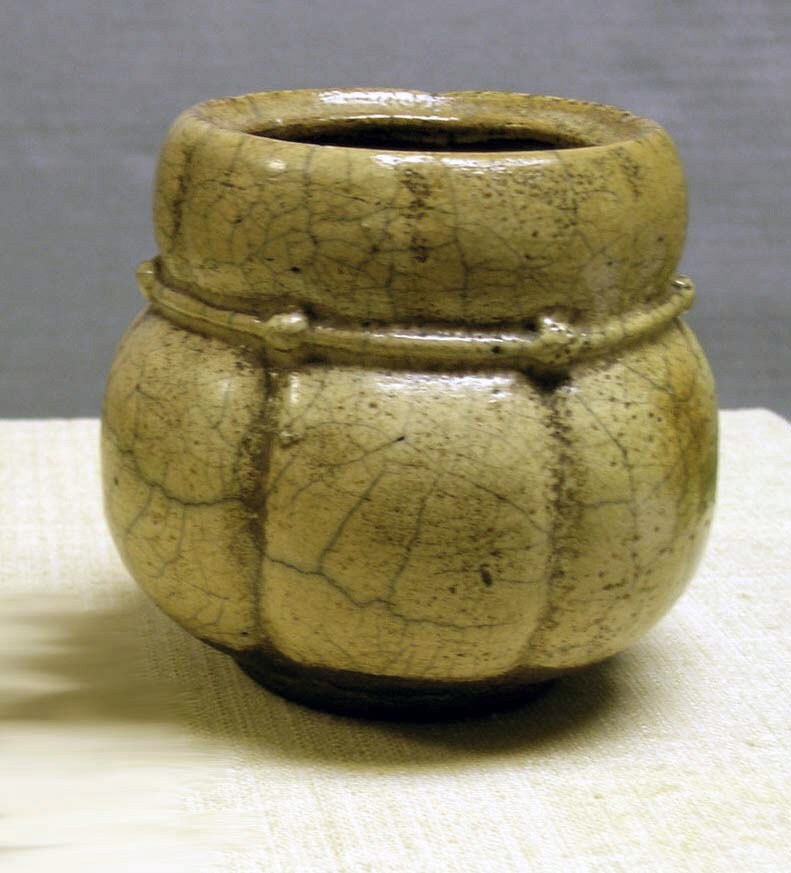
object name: incense burner lid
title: Incense burner with lid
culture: japanese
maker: jokei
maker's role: artist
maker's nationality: japanese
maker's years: 1536-1636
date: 1601-1700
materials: brass, earthenware, glaze